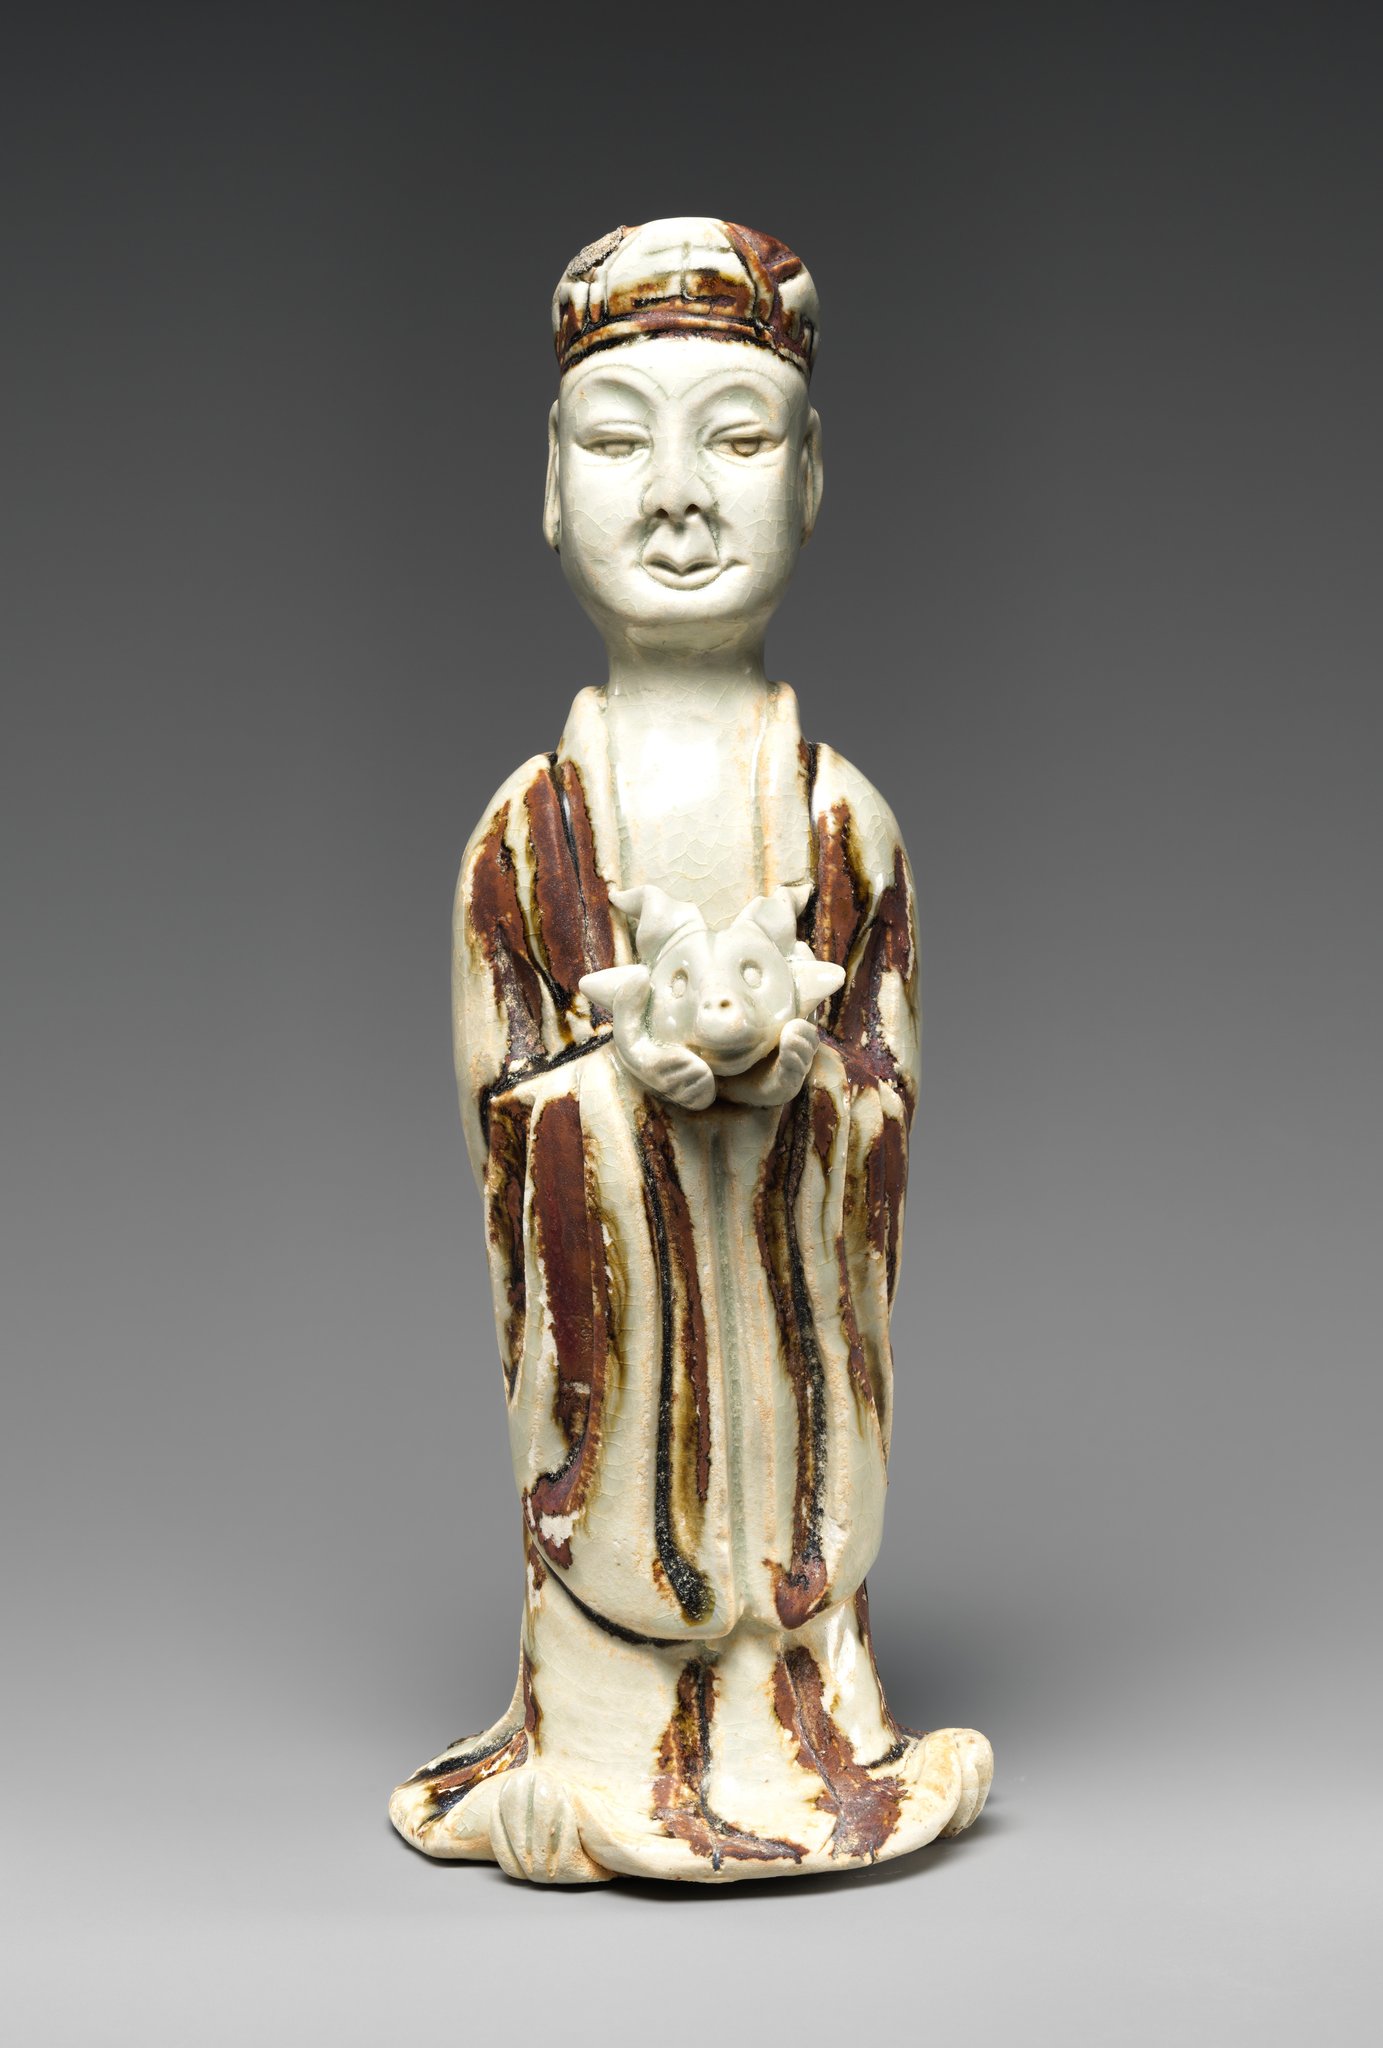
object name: figure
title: Daoist Priest with Zodiac Animal, Ram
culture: chinese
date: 960-1279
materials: stoneware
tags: men,zodiac